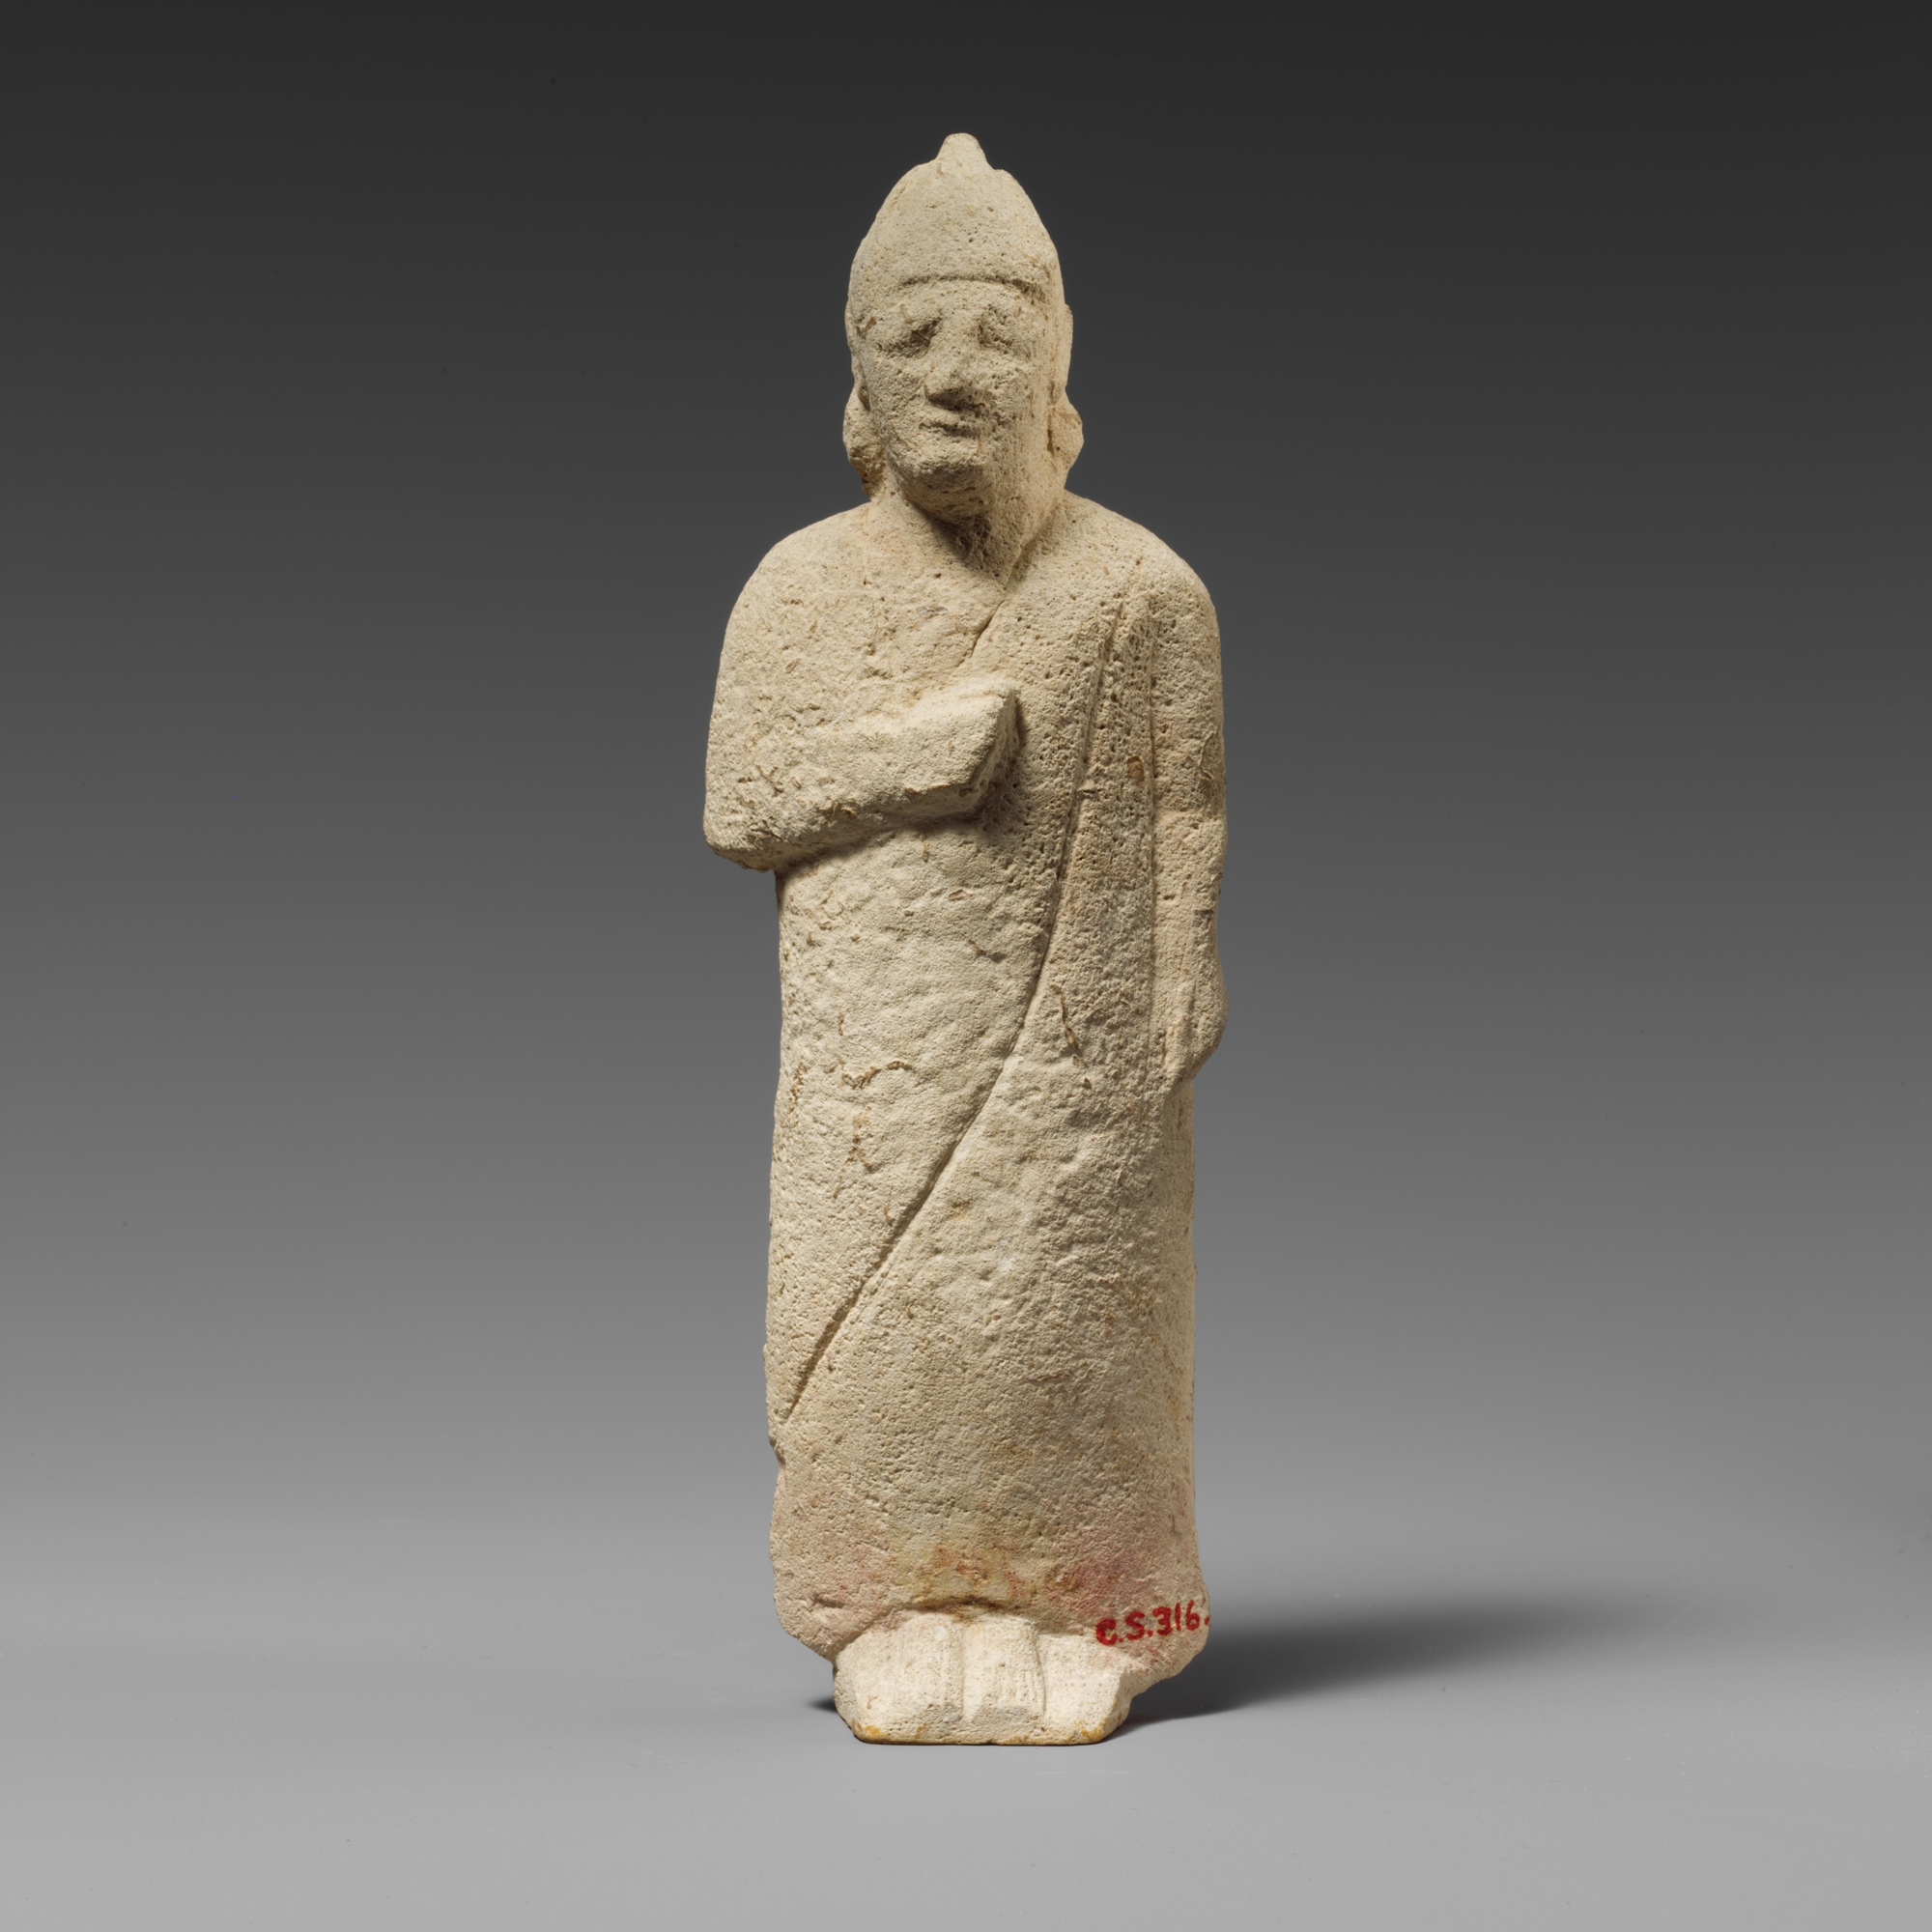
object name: statuette of a votary, male, with pointed cap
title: Limestone statuette of a beardless male votary with a conical helmet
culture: cypriot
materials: limestone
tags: helmets,men